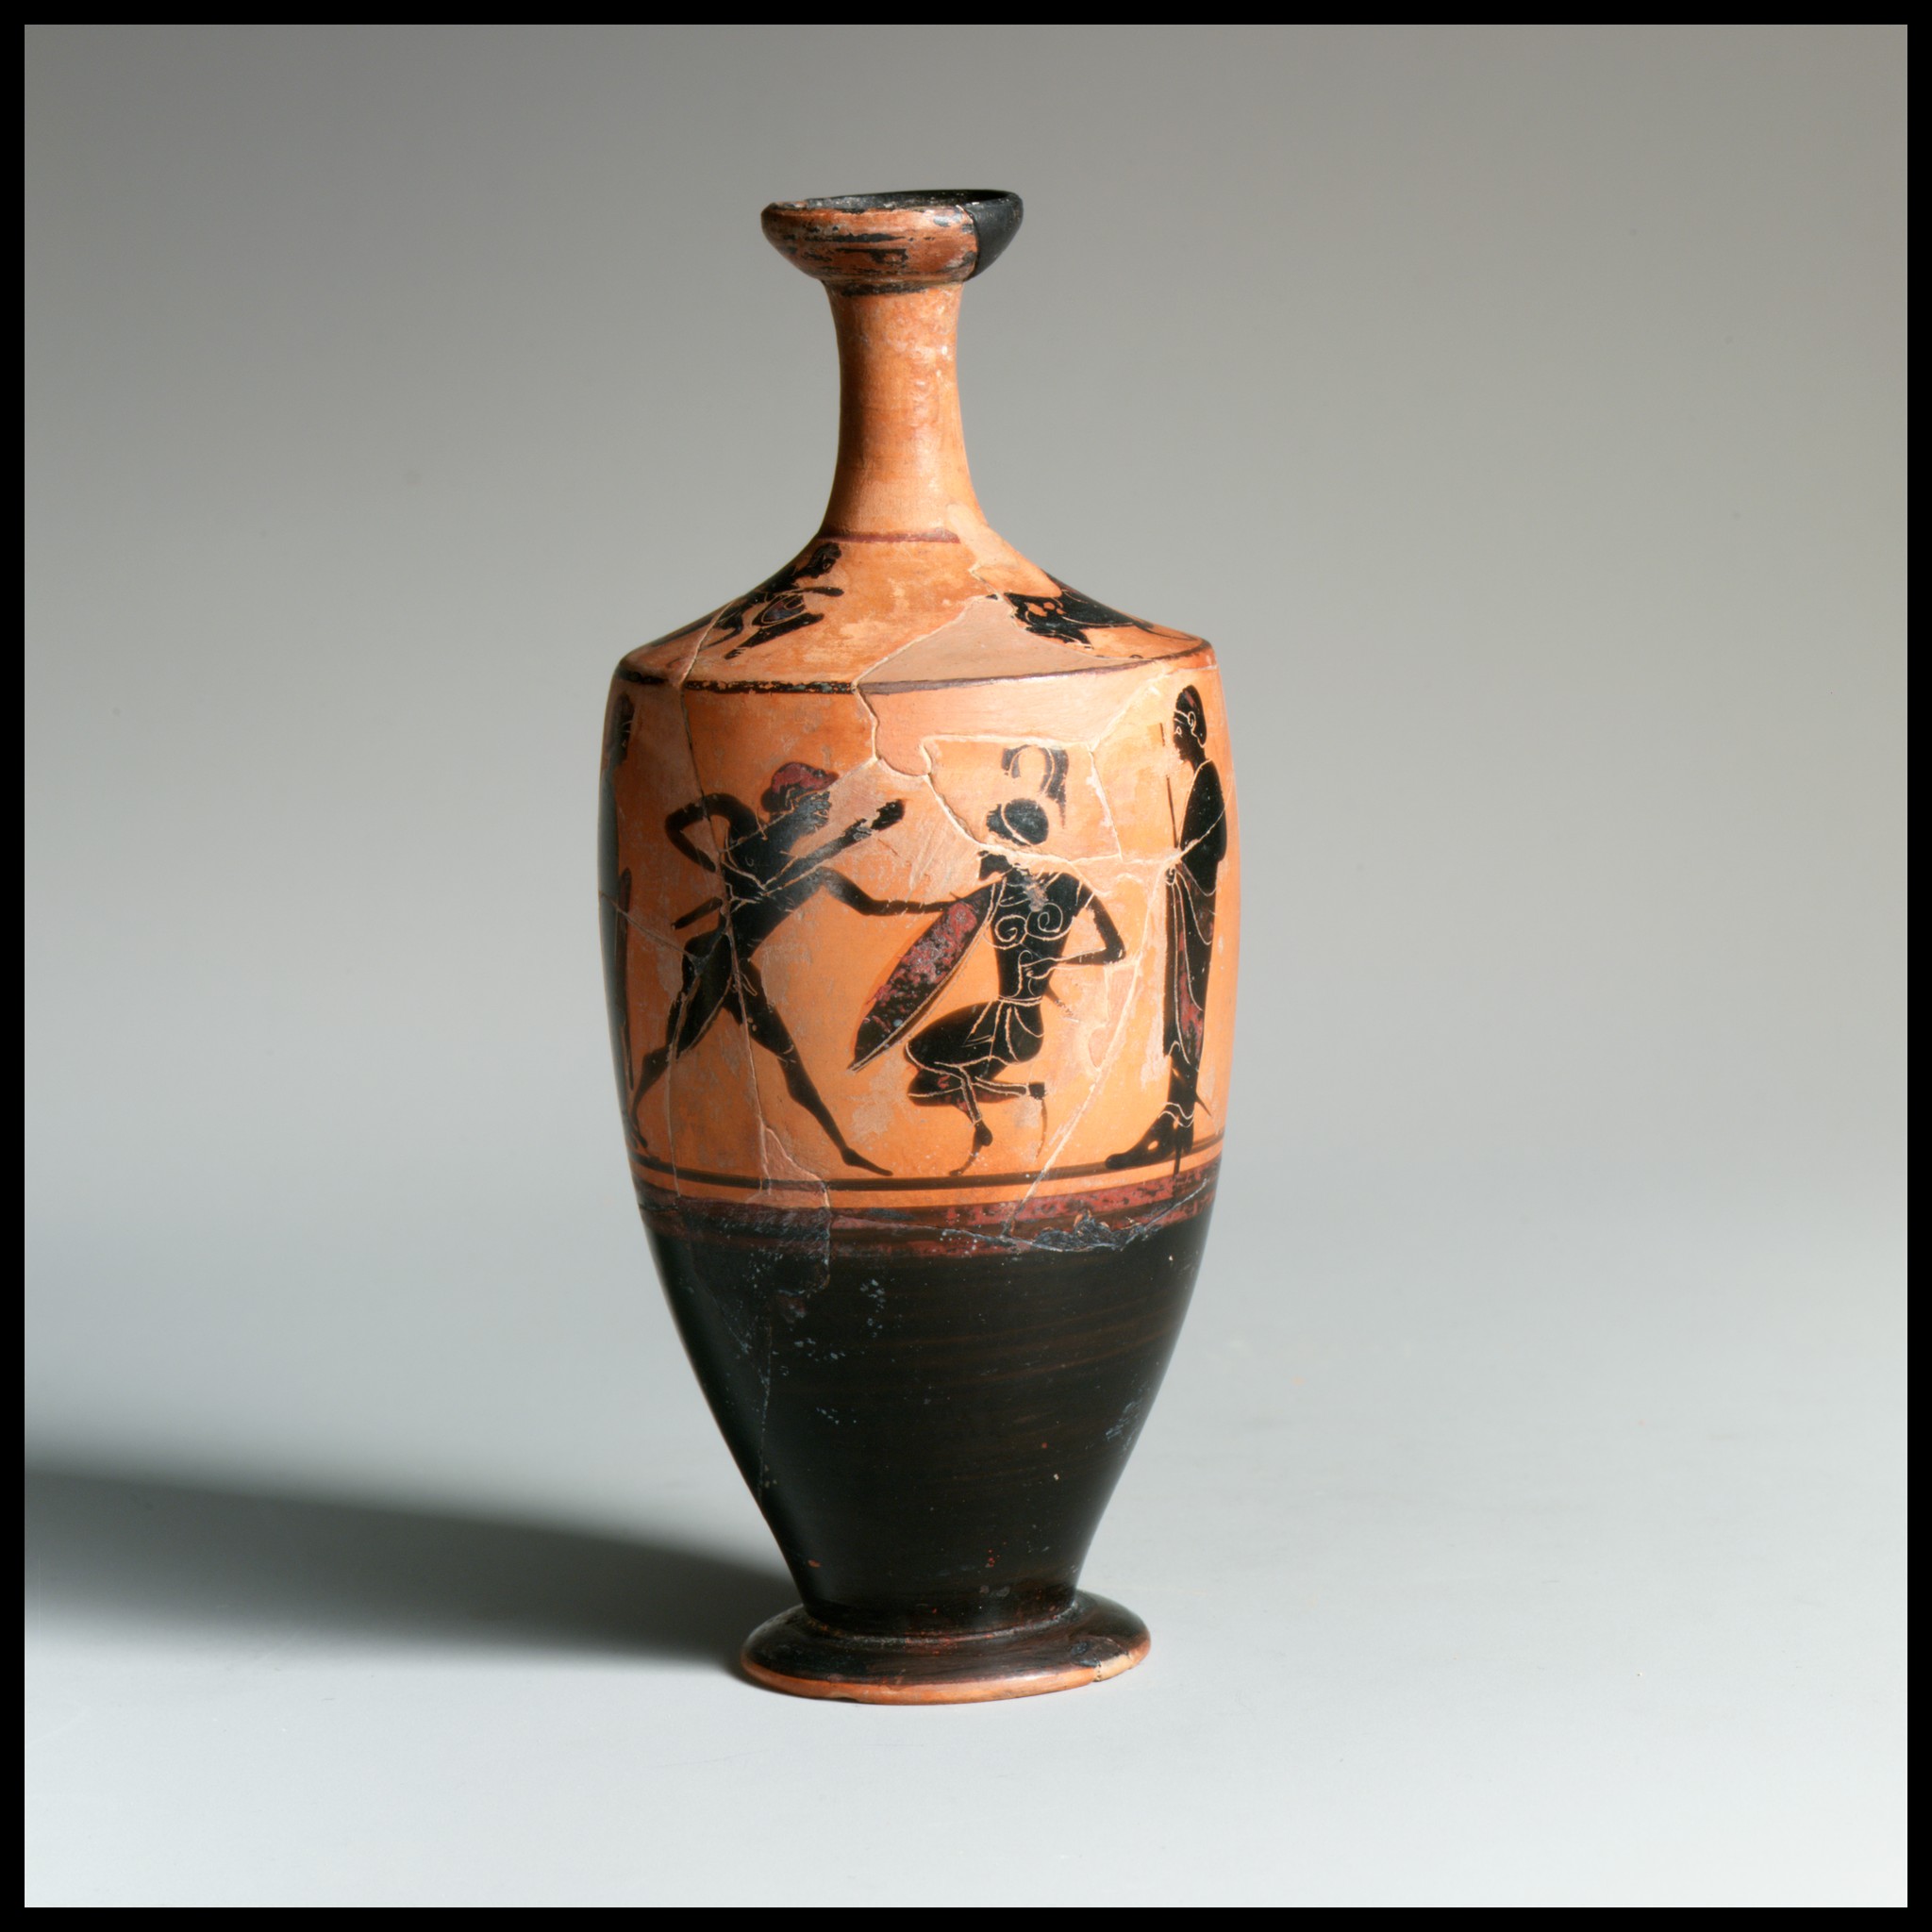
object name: lekythos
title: Terracotta lekythos (oil flask)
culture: greek, attic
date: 500 BCE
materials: terracotta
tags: herakles